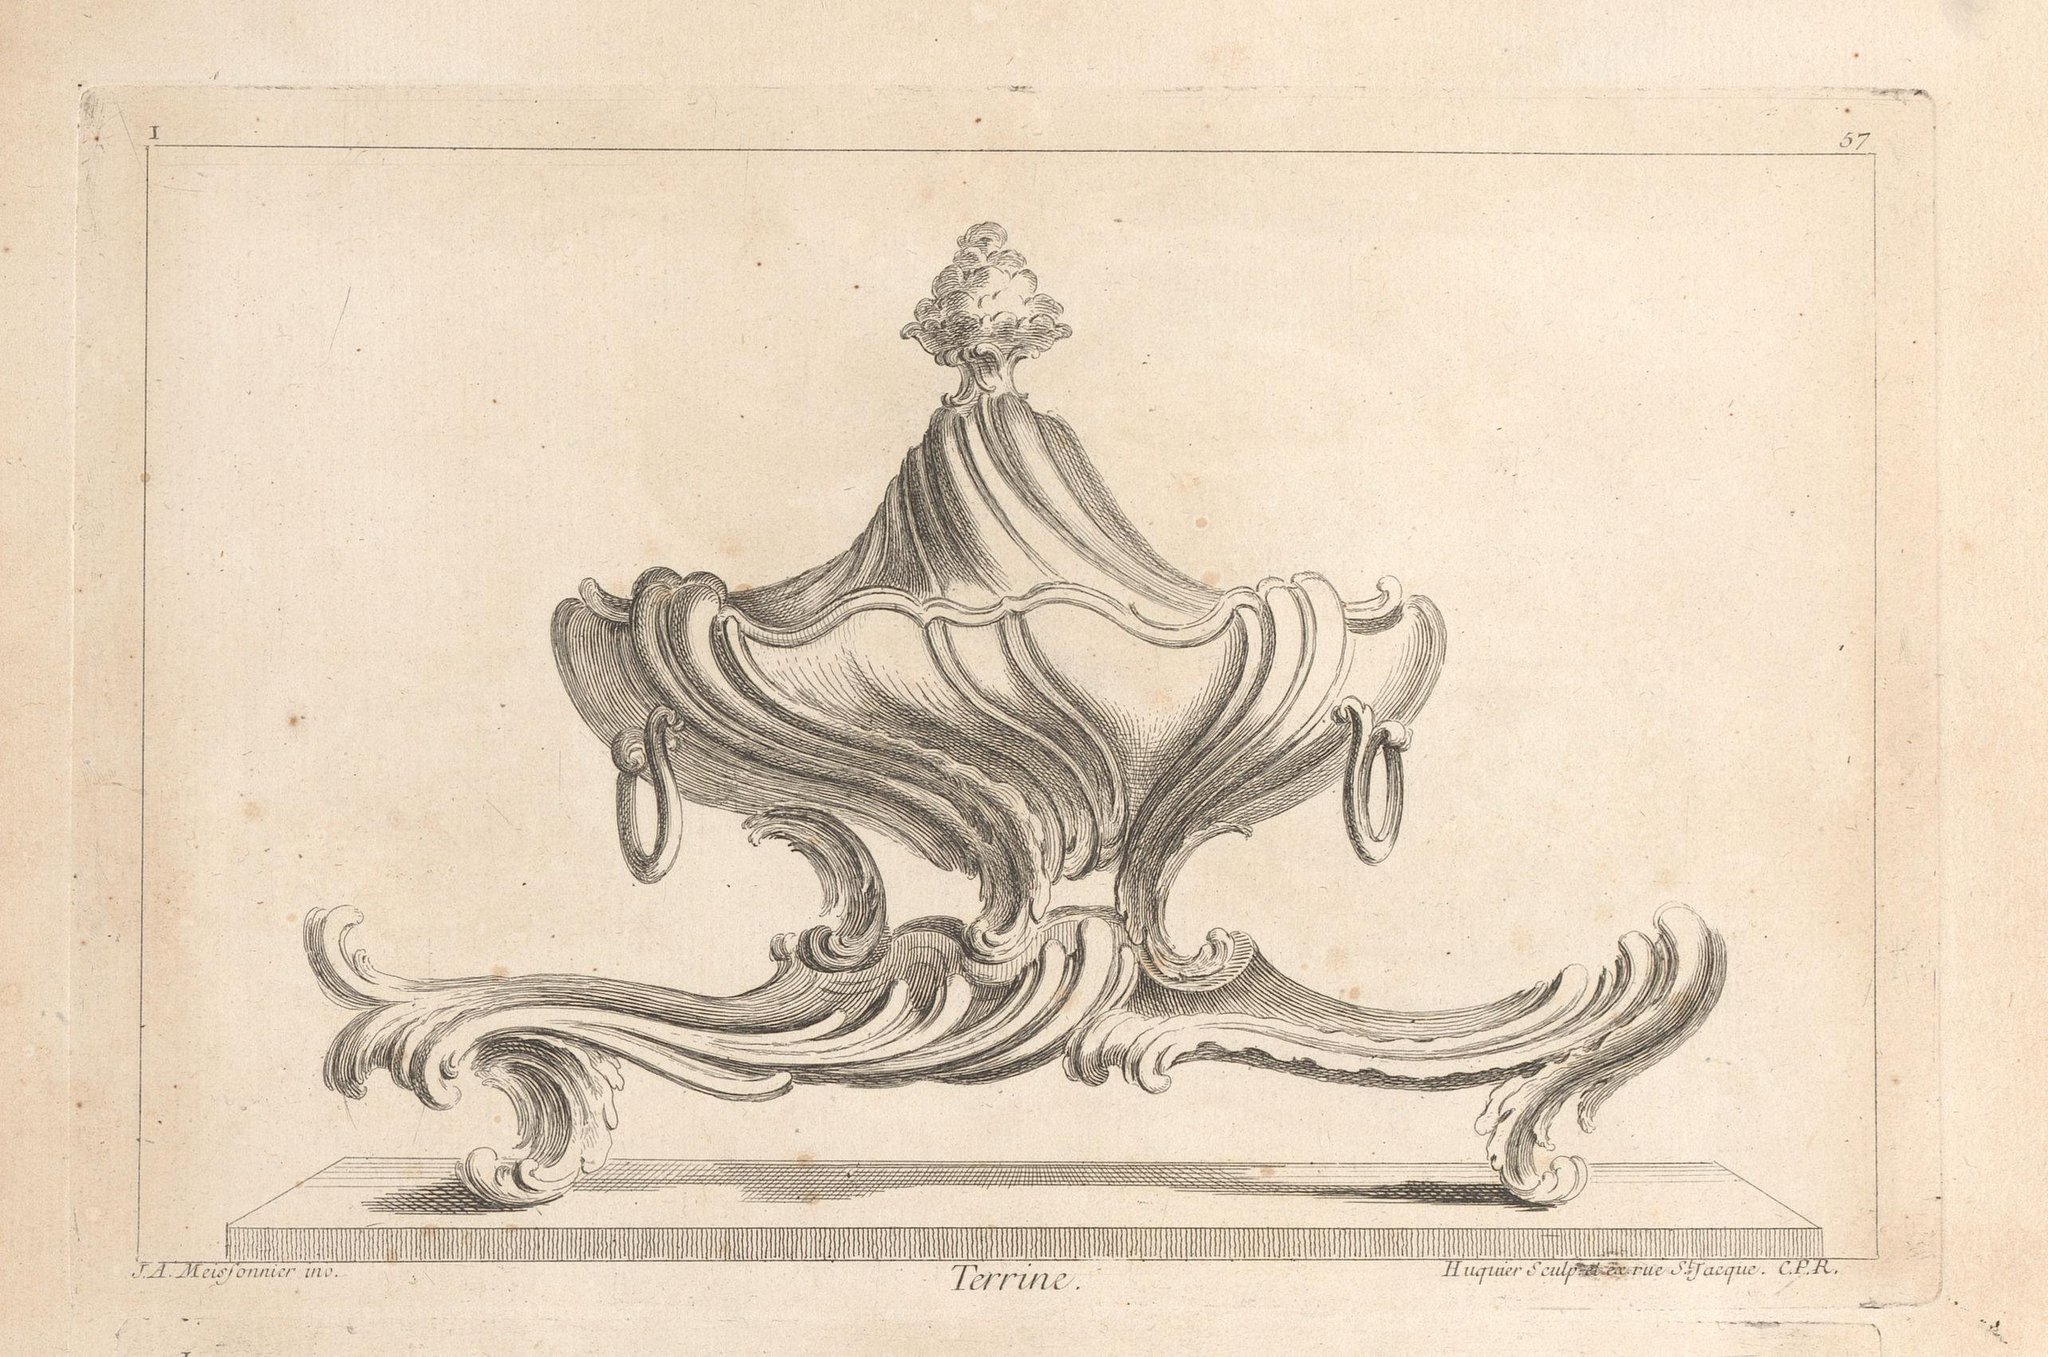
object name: album leaf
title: Oeuvre van Juste Aurele Meissonnier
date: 1738-1749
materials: paper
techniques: etching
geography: paris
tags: serving-dish, platter, work of applied art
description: Deze prent maakt deel uit van de serie "Neuvième livre des oeuvres de mr. Messonnier", een van de delen van de monumentale serie "Oeuvre de Juste Aurele Meissonnier".